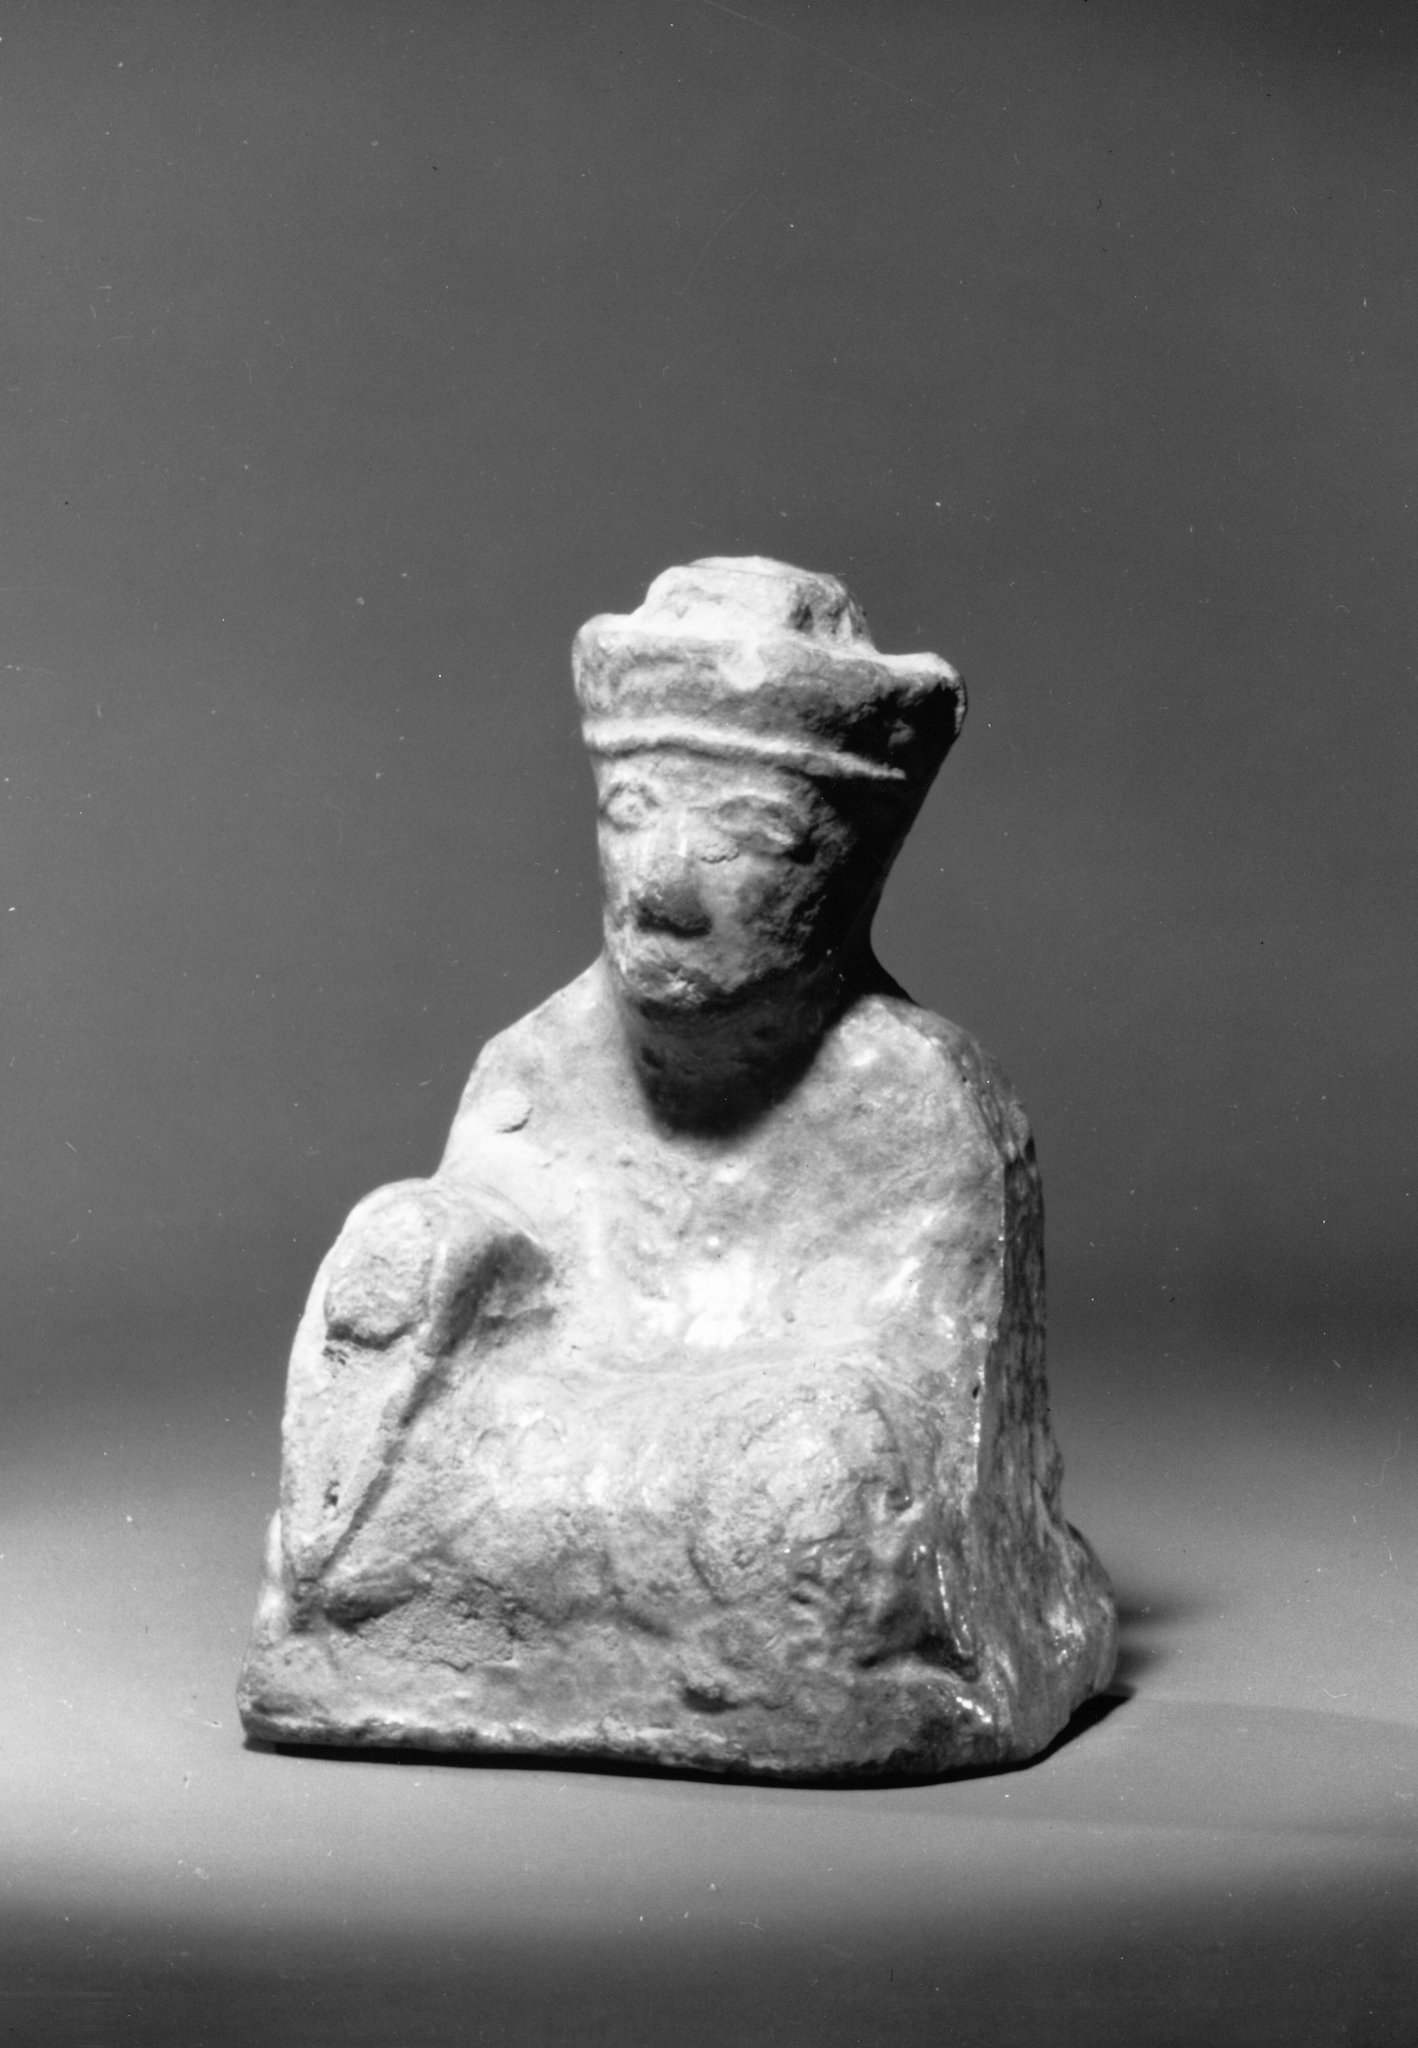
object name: figure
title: Miniature figure of a seated man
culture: chinese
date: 1-200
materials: earthenware, glaze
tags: men